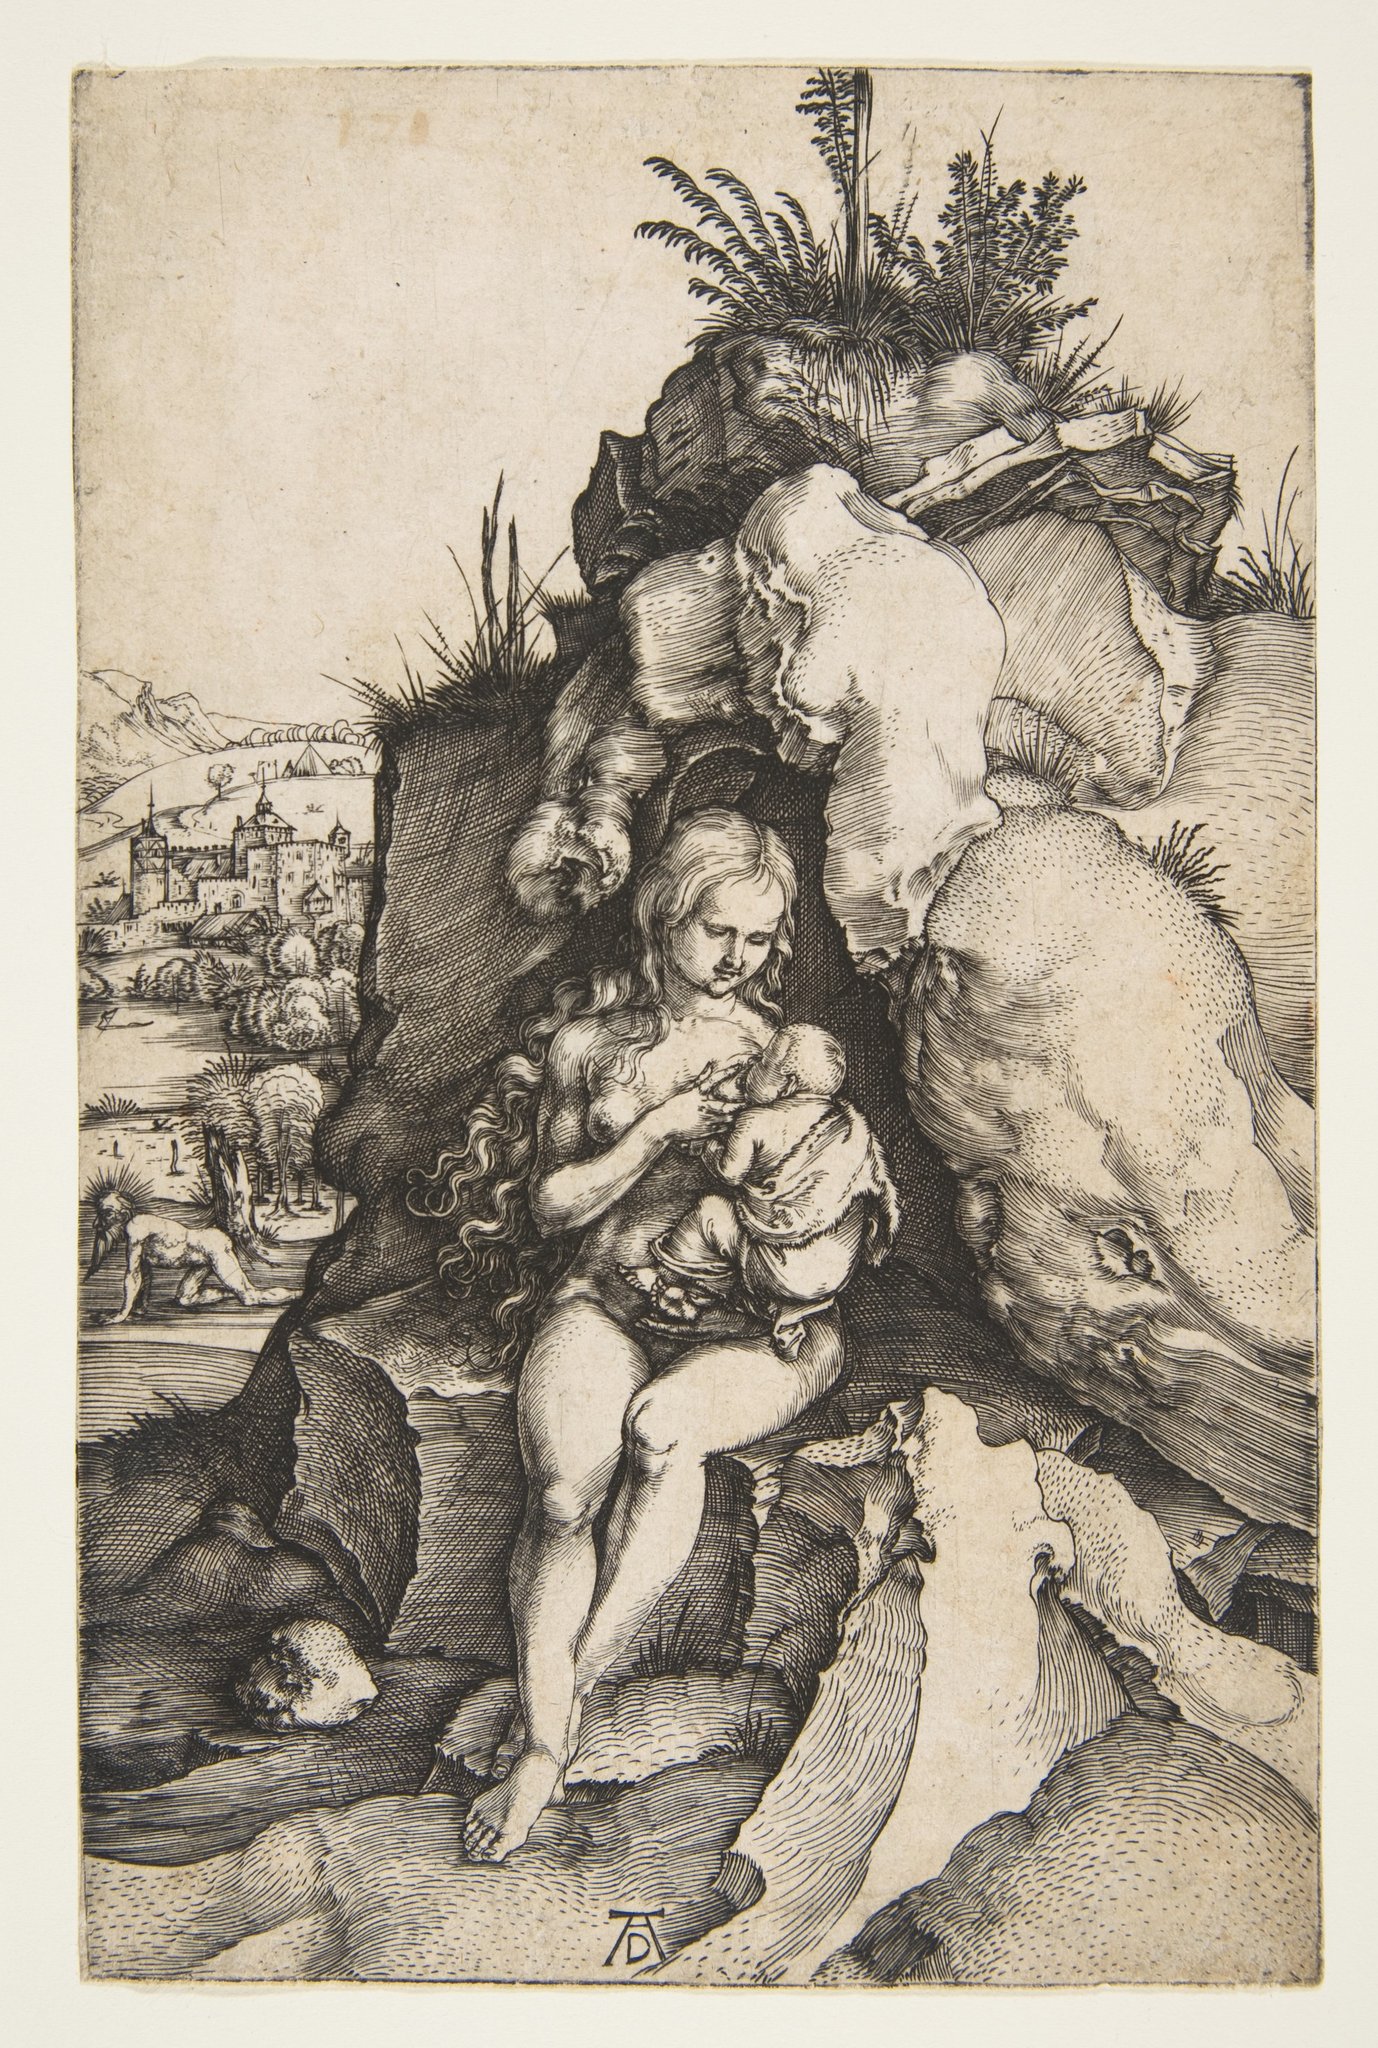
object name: print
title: The Penance of Saint John Chrysostom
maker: albrecht dürer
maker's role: artist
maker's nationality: german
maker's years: 1471-1528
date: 1496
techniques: engraving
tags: infants,female nudes,nursing